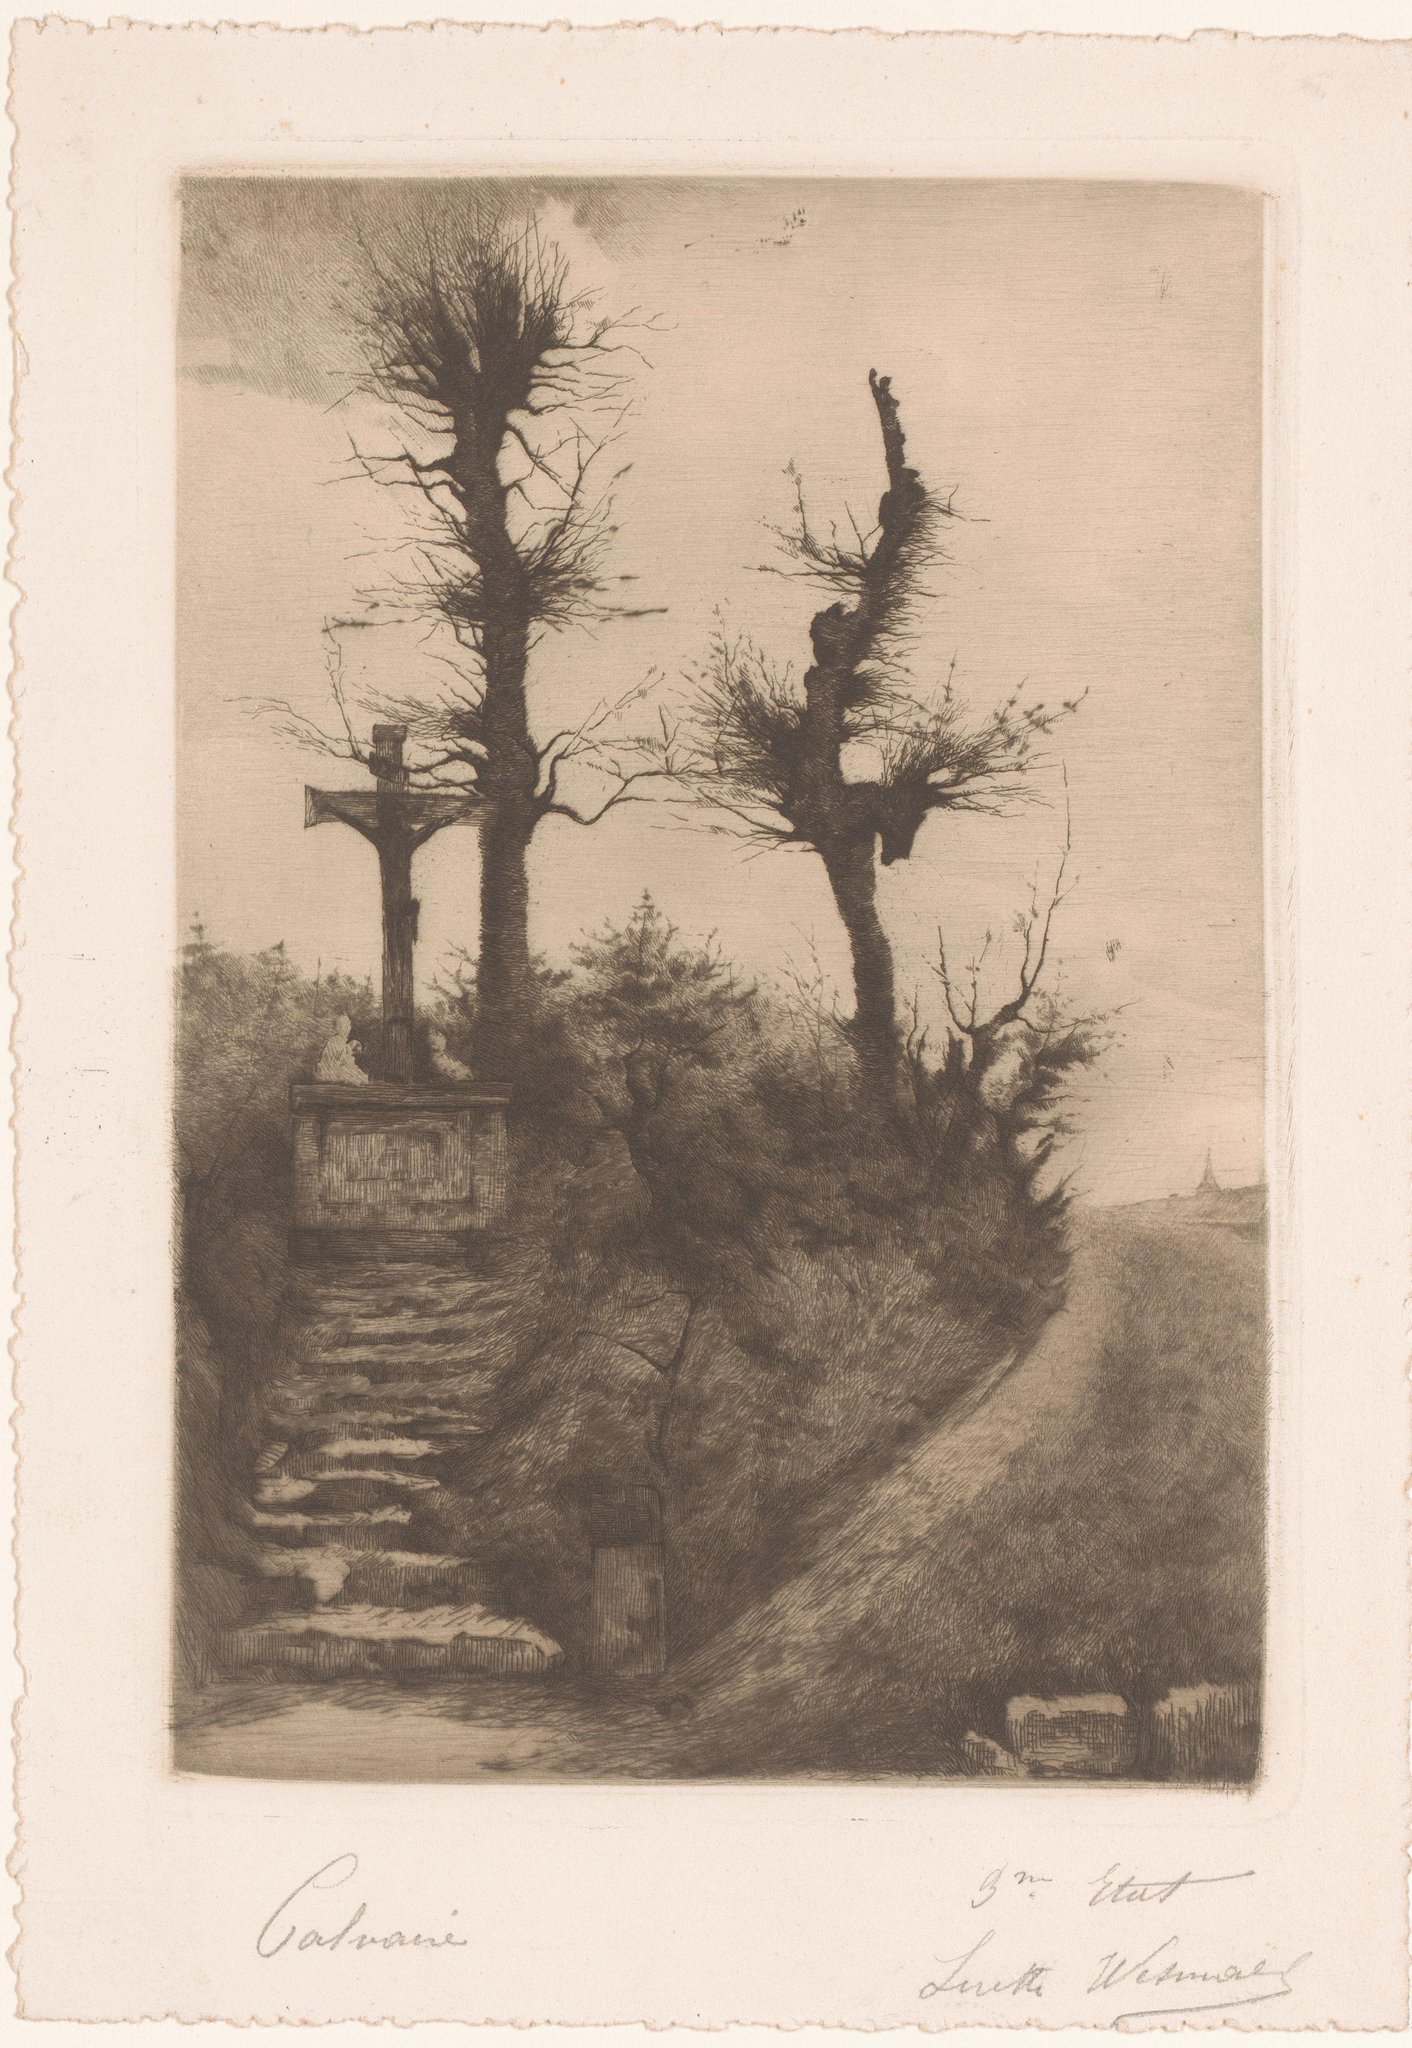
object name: print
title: Kruis op een heuvel te Nimy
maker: lisette wesmael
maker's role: print maker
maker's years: 1861-1953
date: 1890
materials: paper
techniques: drypoint, etching, intaglio, retroussage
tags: crucifix ~ personal devotion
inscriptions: collector's mark: Lugt 2228